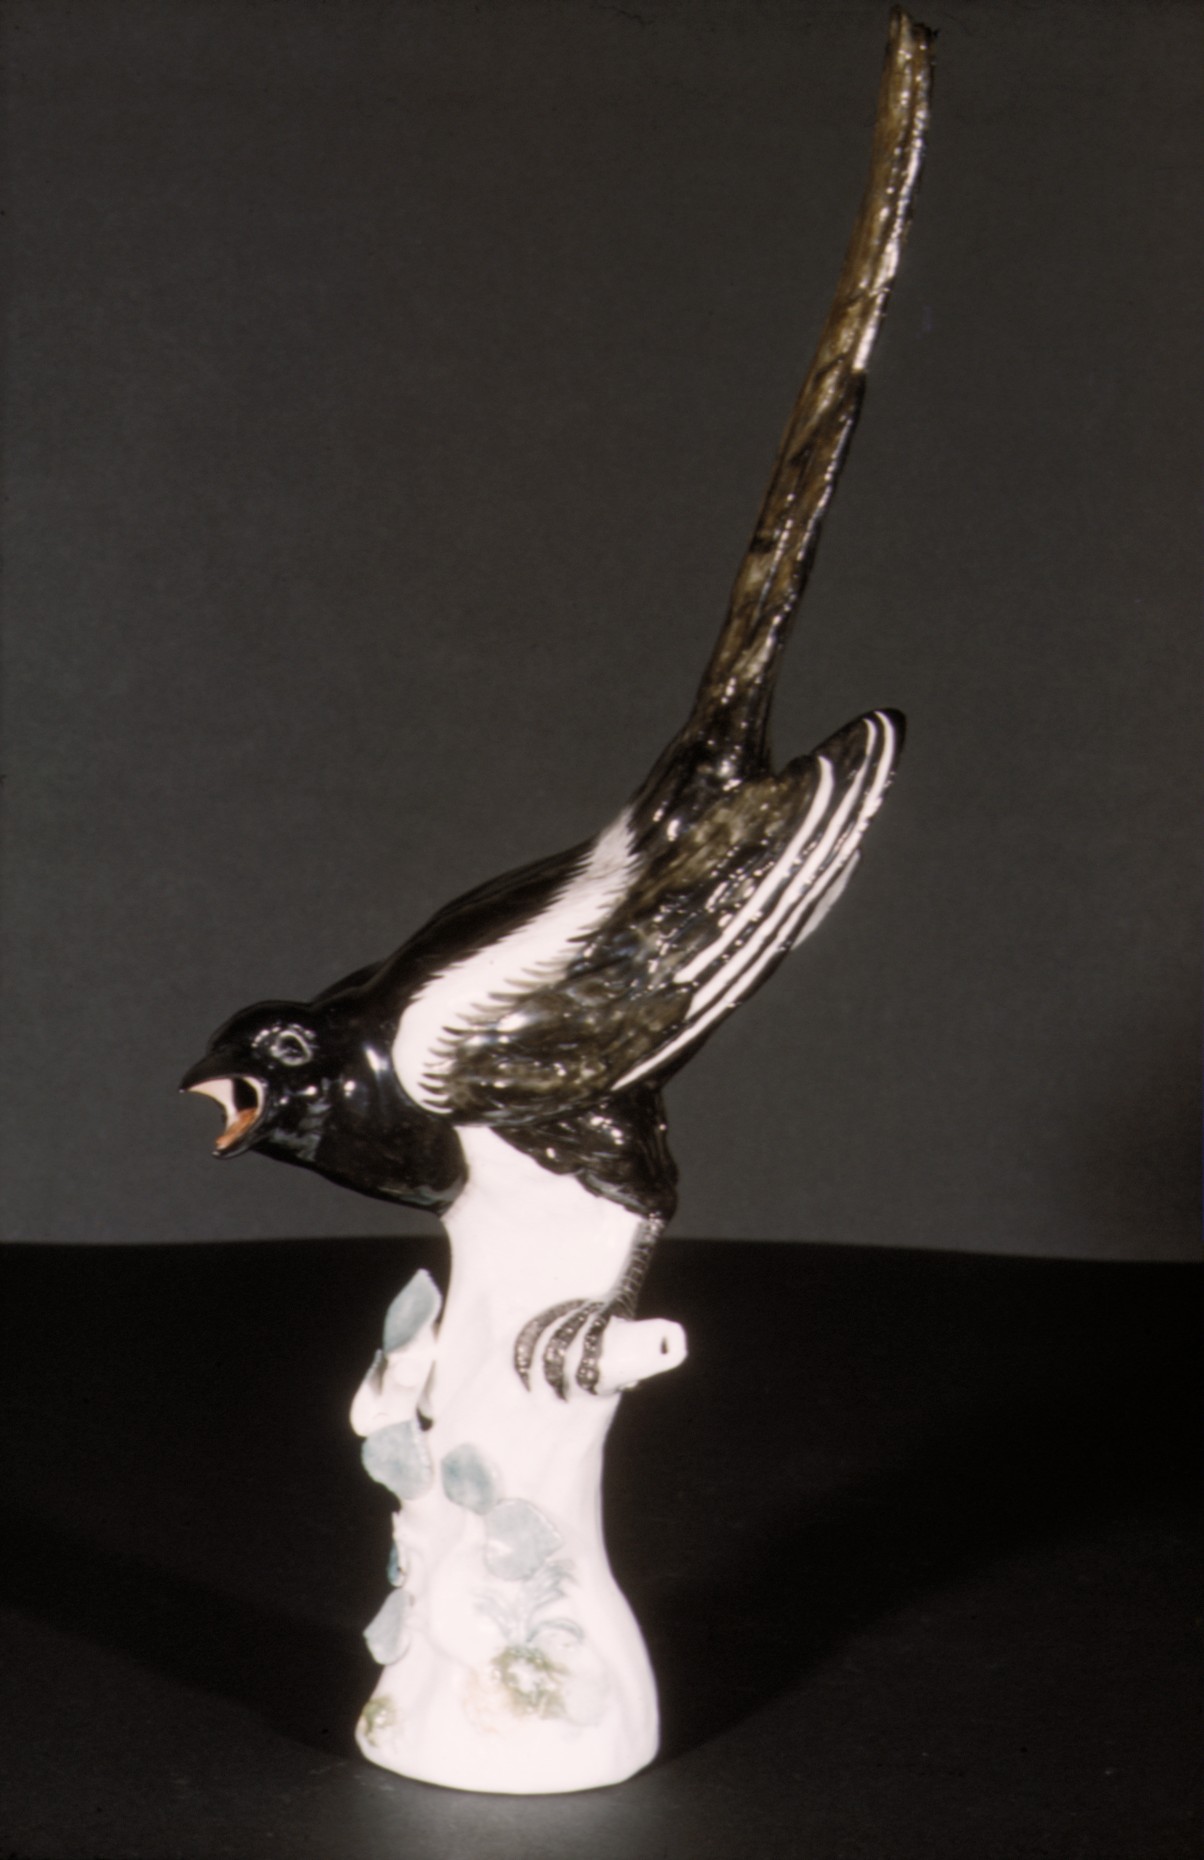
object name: figure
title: Magpie (one of a pair)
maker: meissen manufactory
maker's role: manufactory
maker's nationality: german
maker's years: 1710-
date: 1733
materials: hard paste porcelain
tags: birds